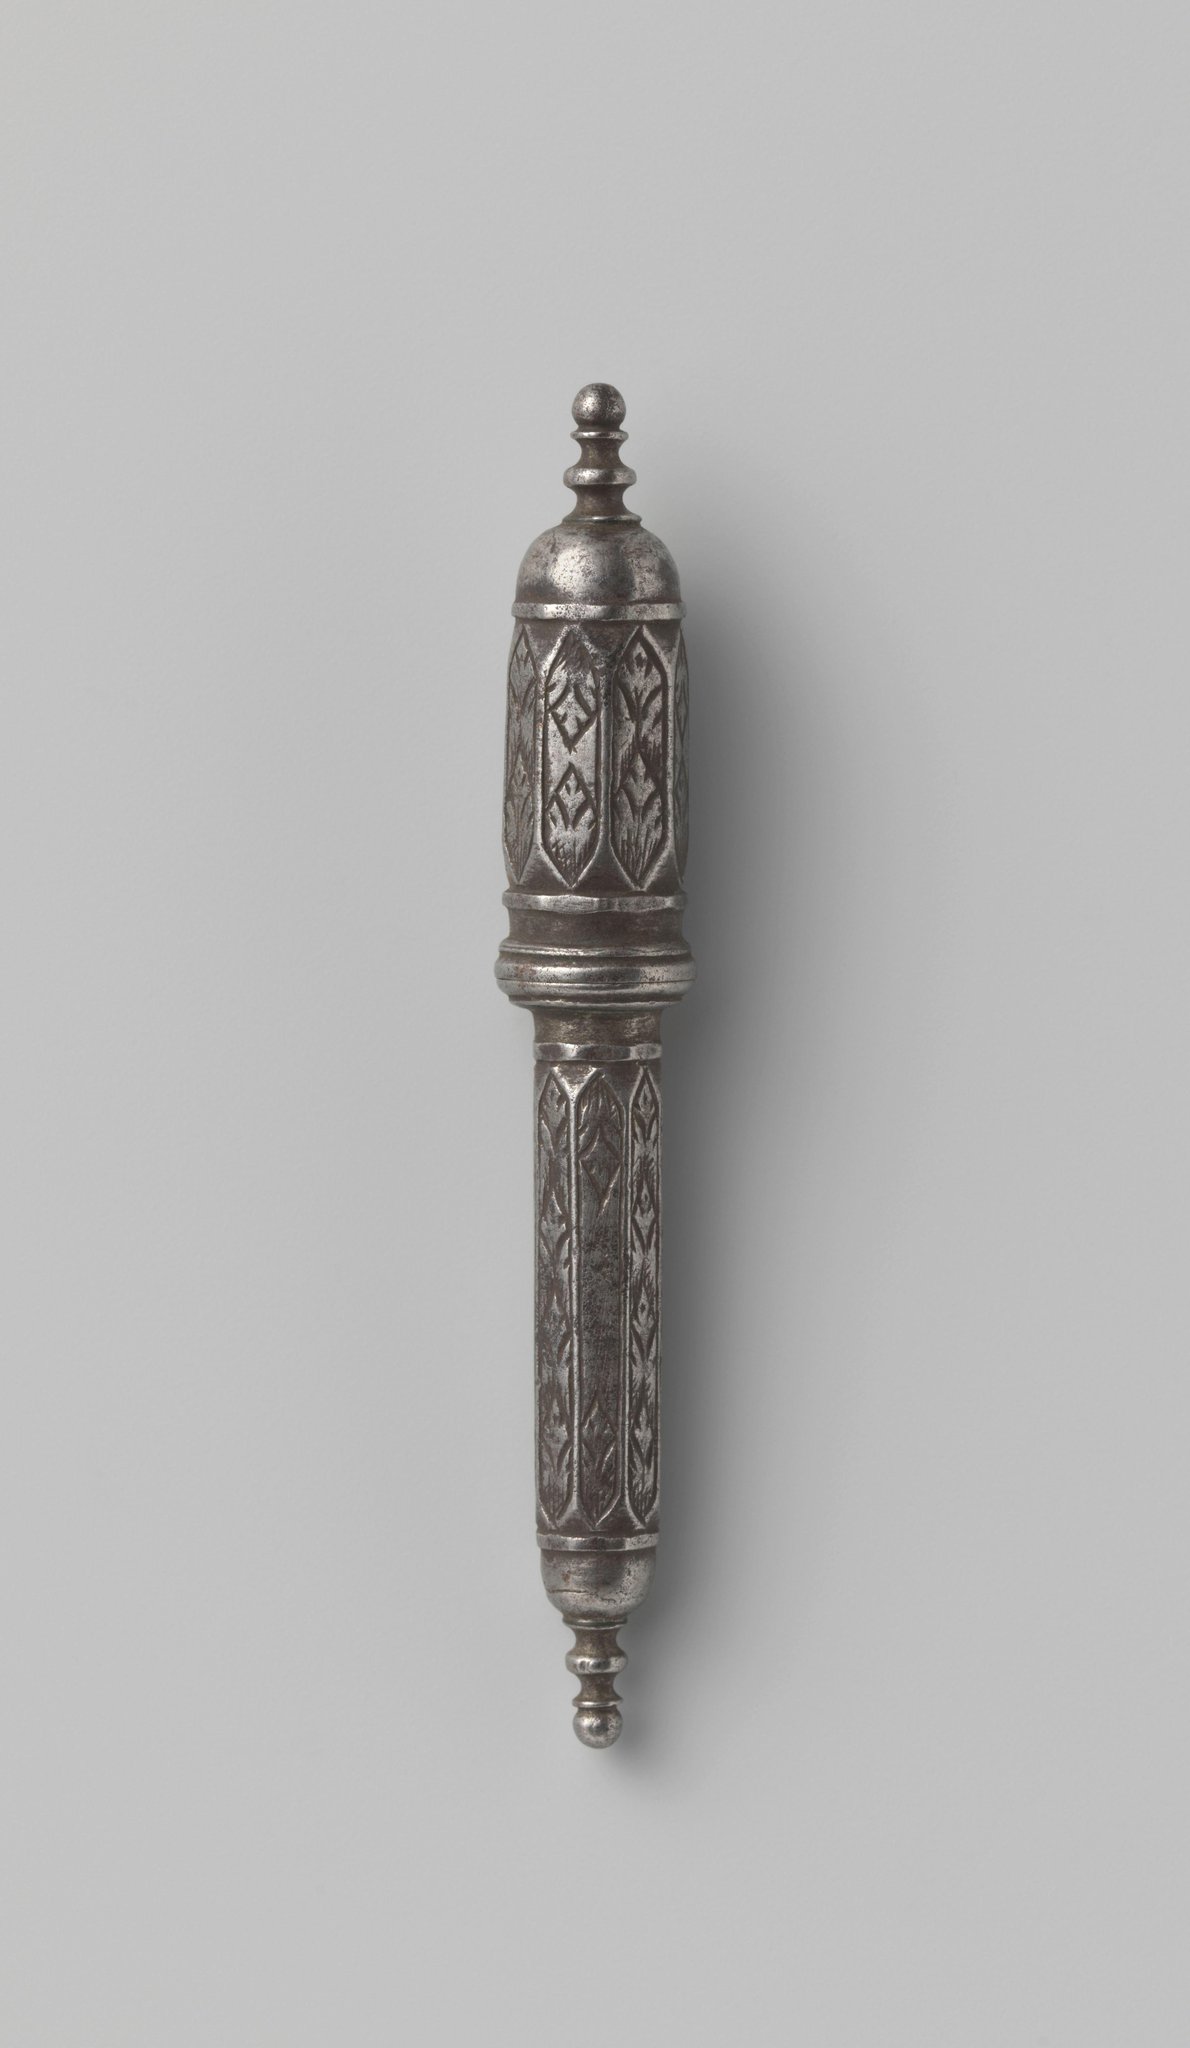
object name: needle case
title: Koker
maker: Anonymous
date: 1700-1800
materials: iron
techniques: forging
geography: france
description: Een gesmeed ijzeren achthoekige naaldenkoker met afschroefbaar deksel door gravure met bladornament versierd.